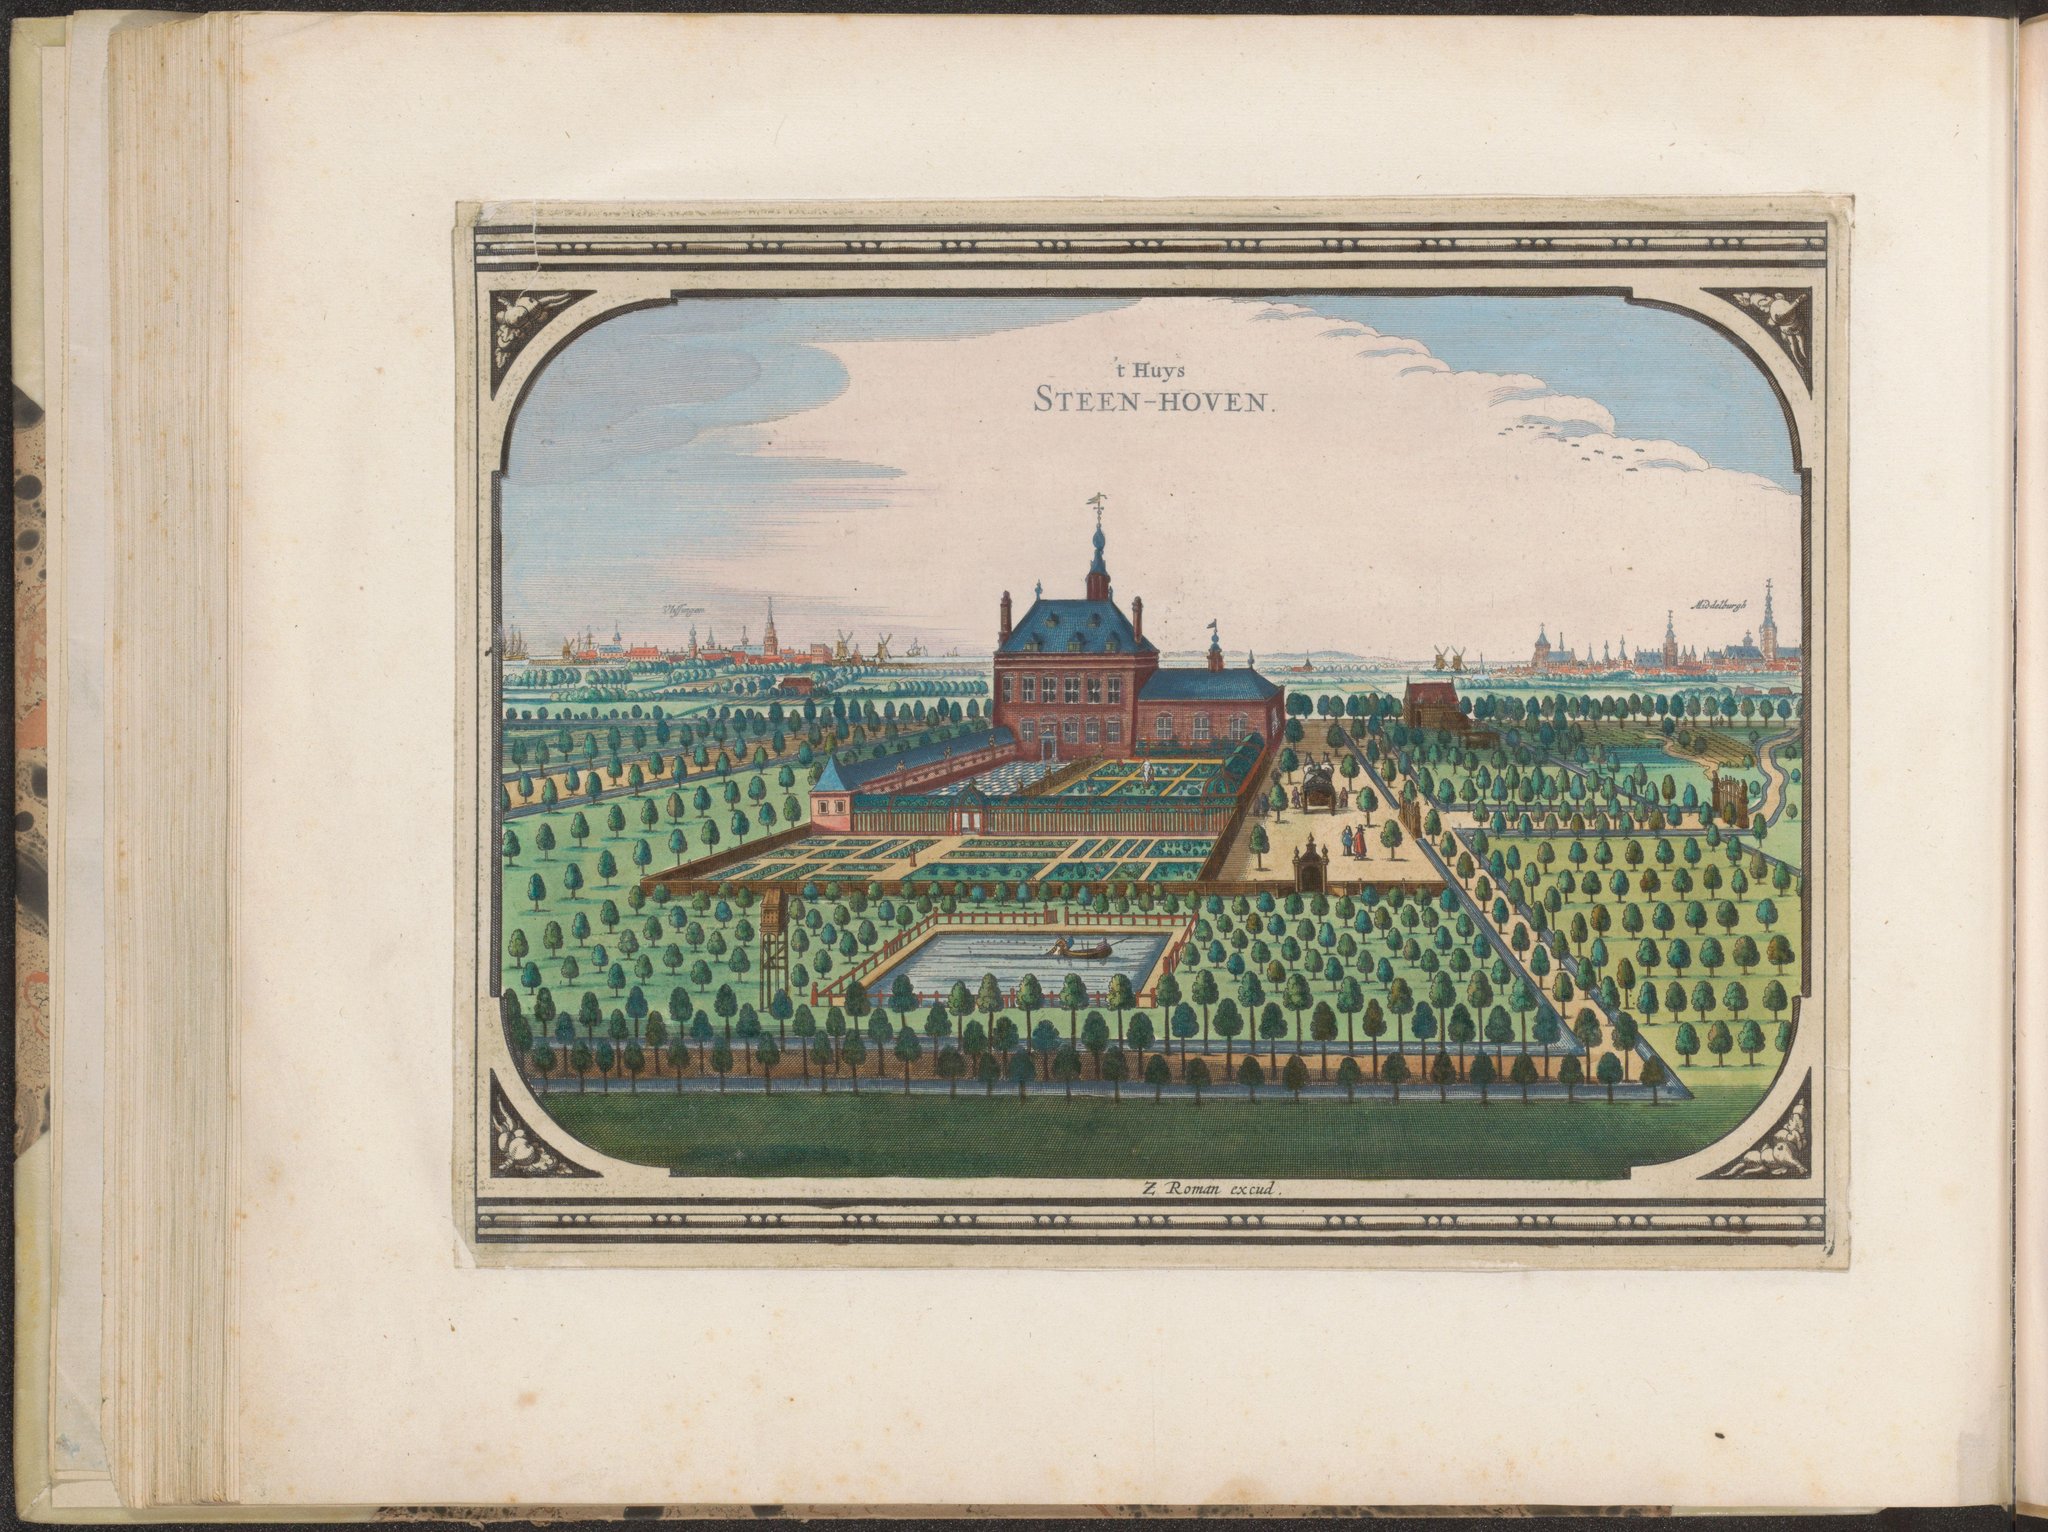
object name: album leaf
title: 't Huys Steen-hoven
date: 1662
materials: paper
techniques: etching, hand coloring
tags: city-view, and landscape with man-made constructions, country-house, middelburg, flushing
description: Gezicht op Huis Steenhoven, een buitenplaats bij Koudekerke op het eiland Walcheren. Op de achtergrond een zicht op de steden Vlissingen en Middelburg. De prent maakt deel uit van een album.